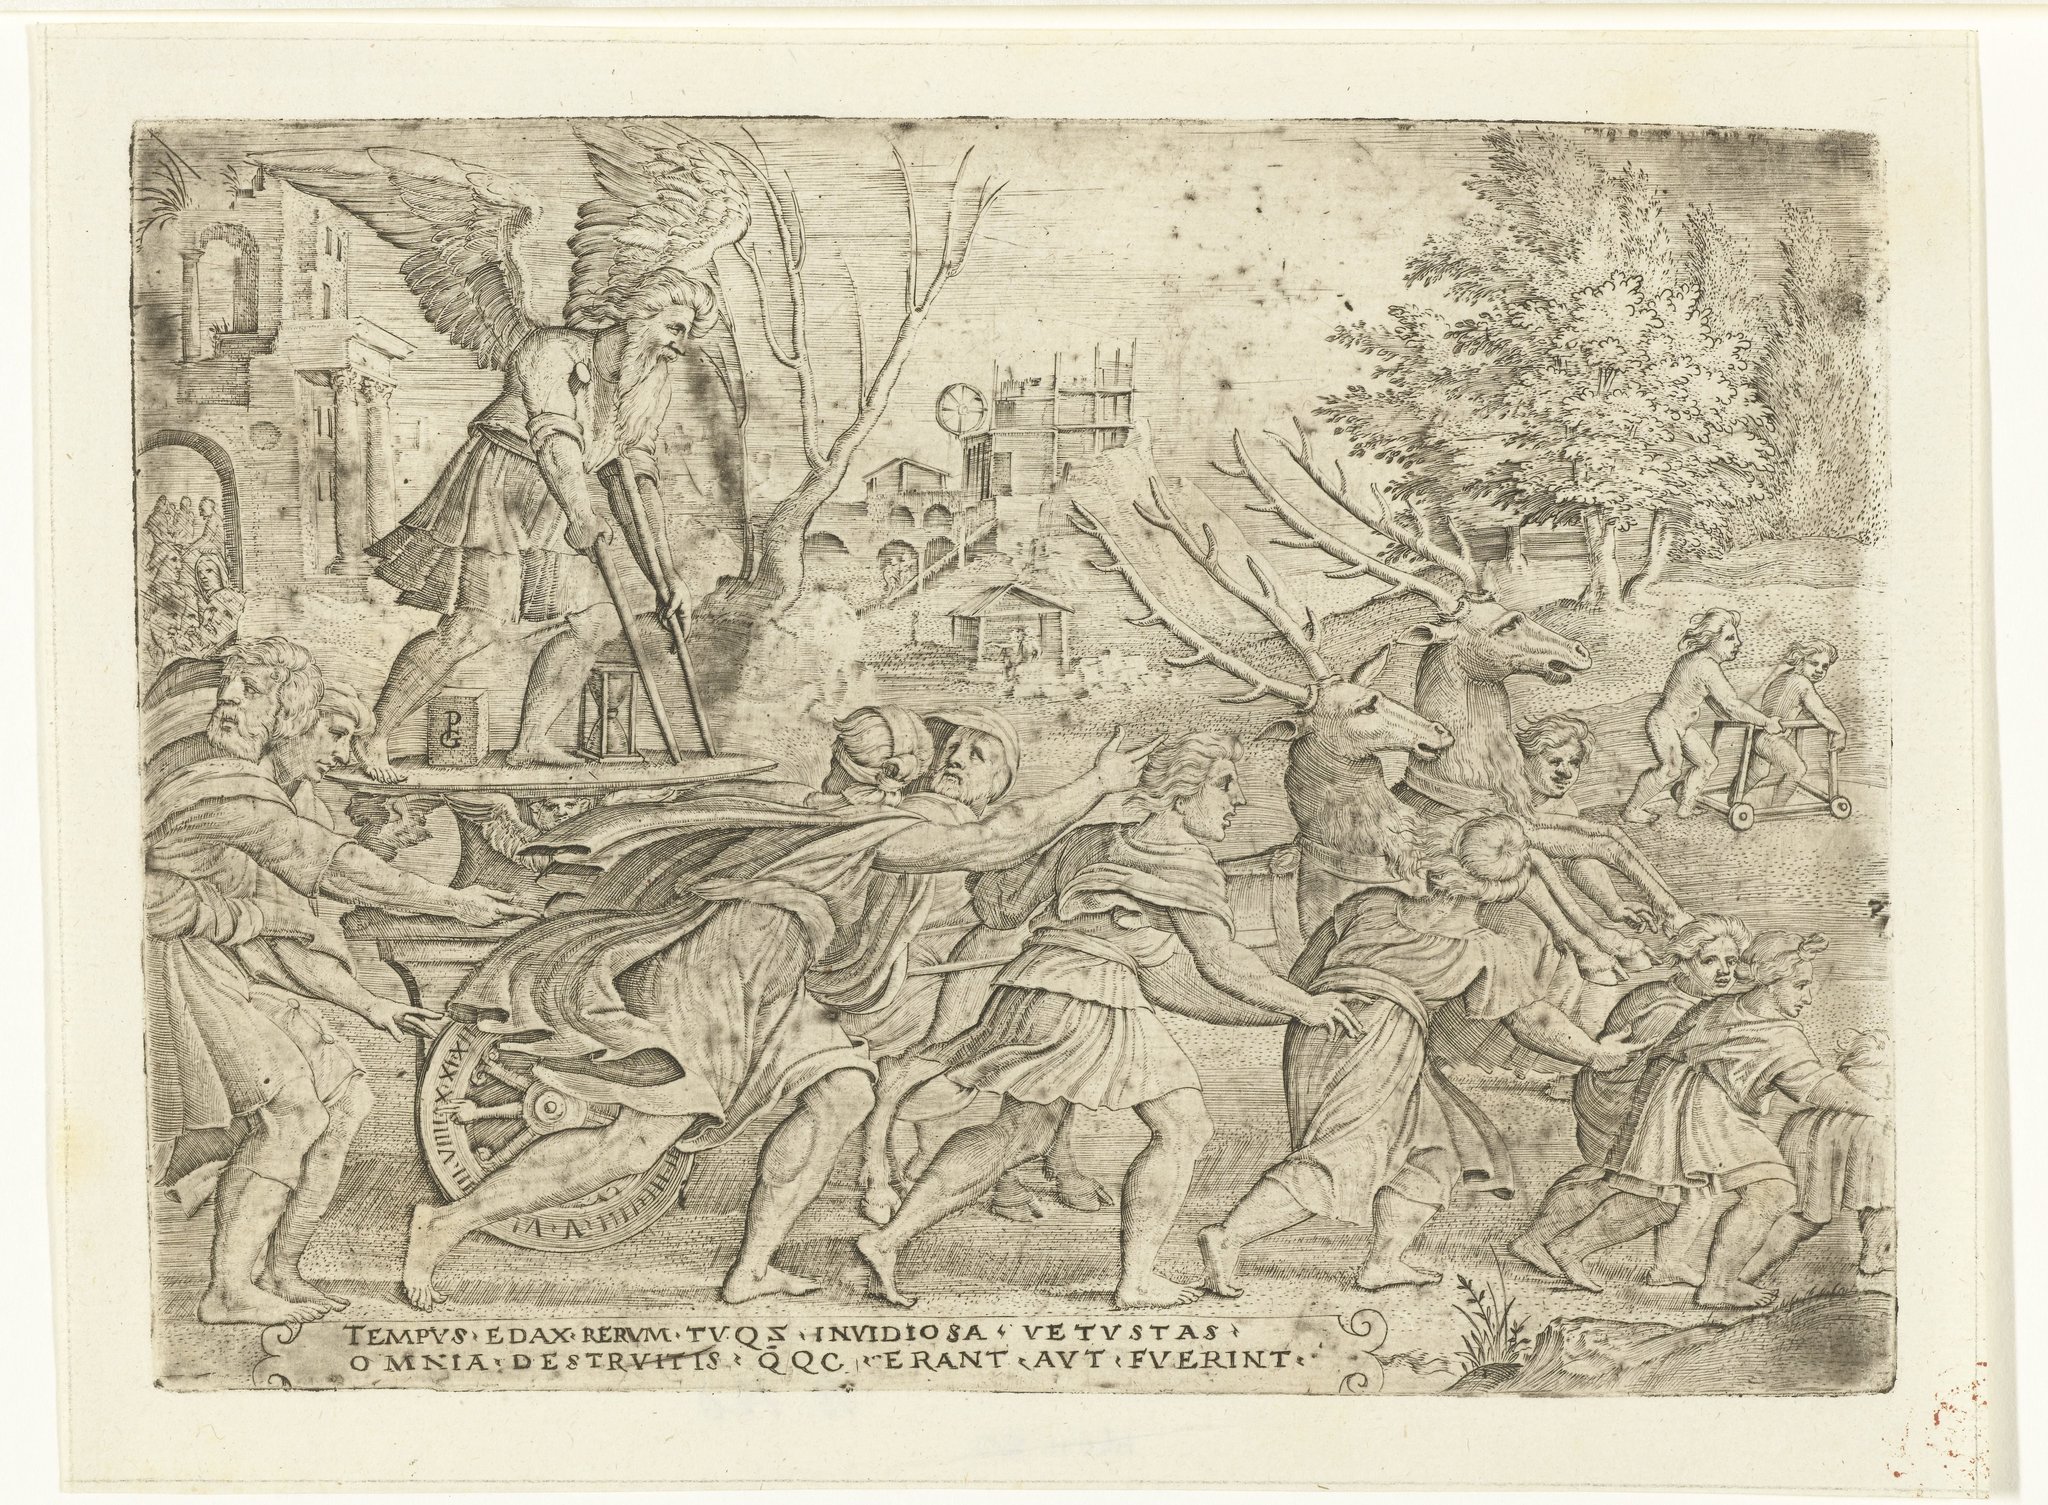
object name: print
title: Triomf van de Tijd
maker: georg pencz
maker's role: draughtsman, painter, print maker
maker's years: 1500-1550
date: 1537-1541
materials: paper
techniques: engraving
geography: germany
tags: 'trionfo del tempo', 'triumphus temporis'; 'carro del tempo' (ripa)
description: De gevleugelde Tijd als een oude man op krukken staat op een wagen die wordt getrokken door herten. In de stoet rennen kinderen en volwassenen mee. Rechts loopt een kind met een looprek, geholpen door een ander kind. Latijns opschrift in twee regels: TEMPVS EDAX RERVM ... ERANT AVT FVERINT